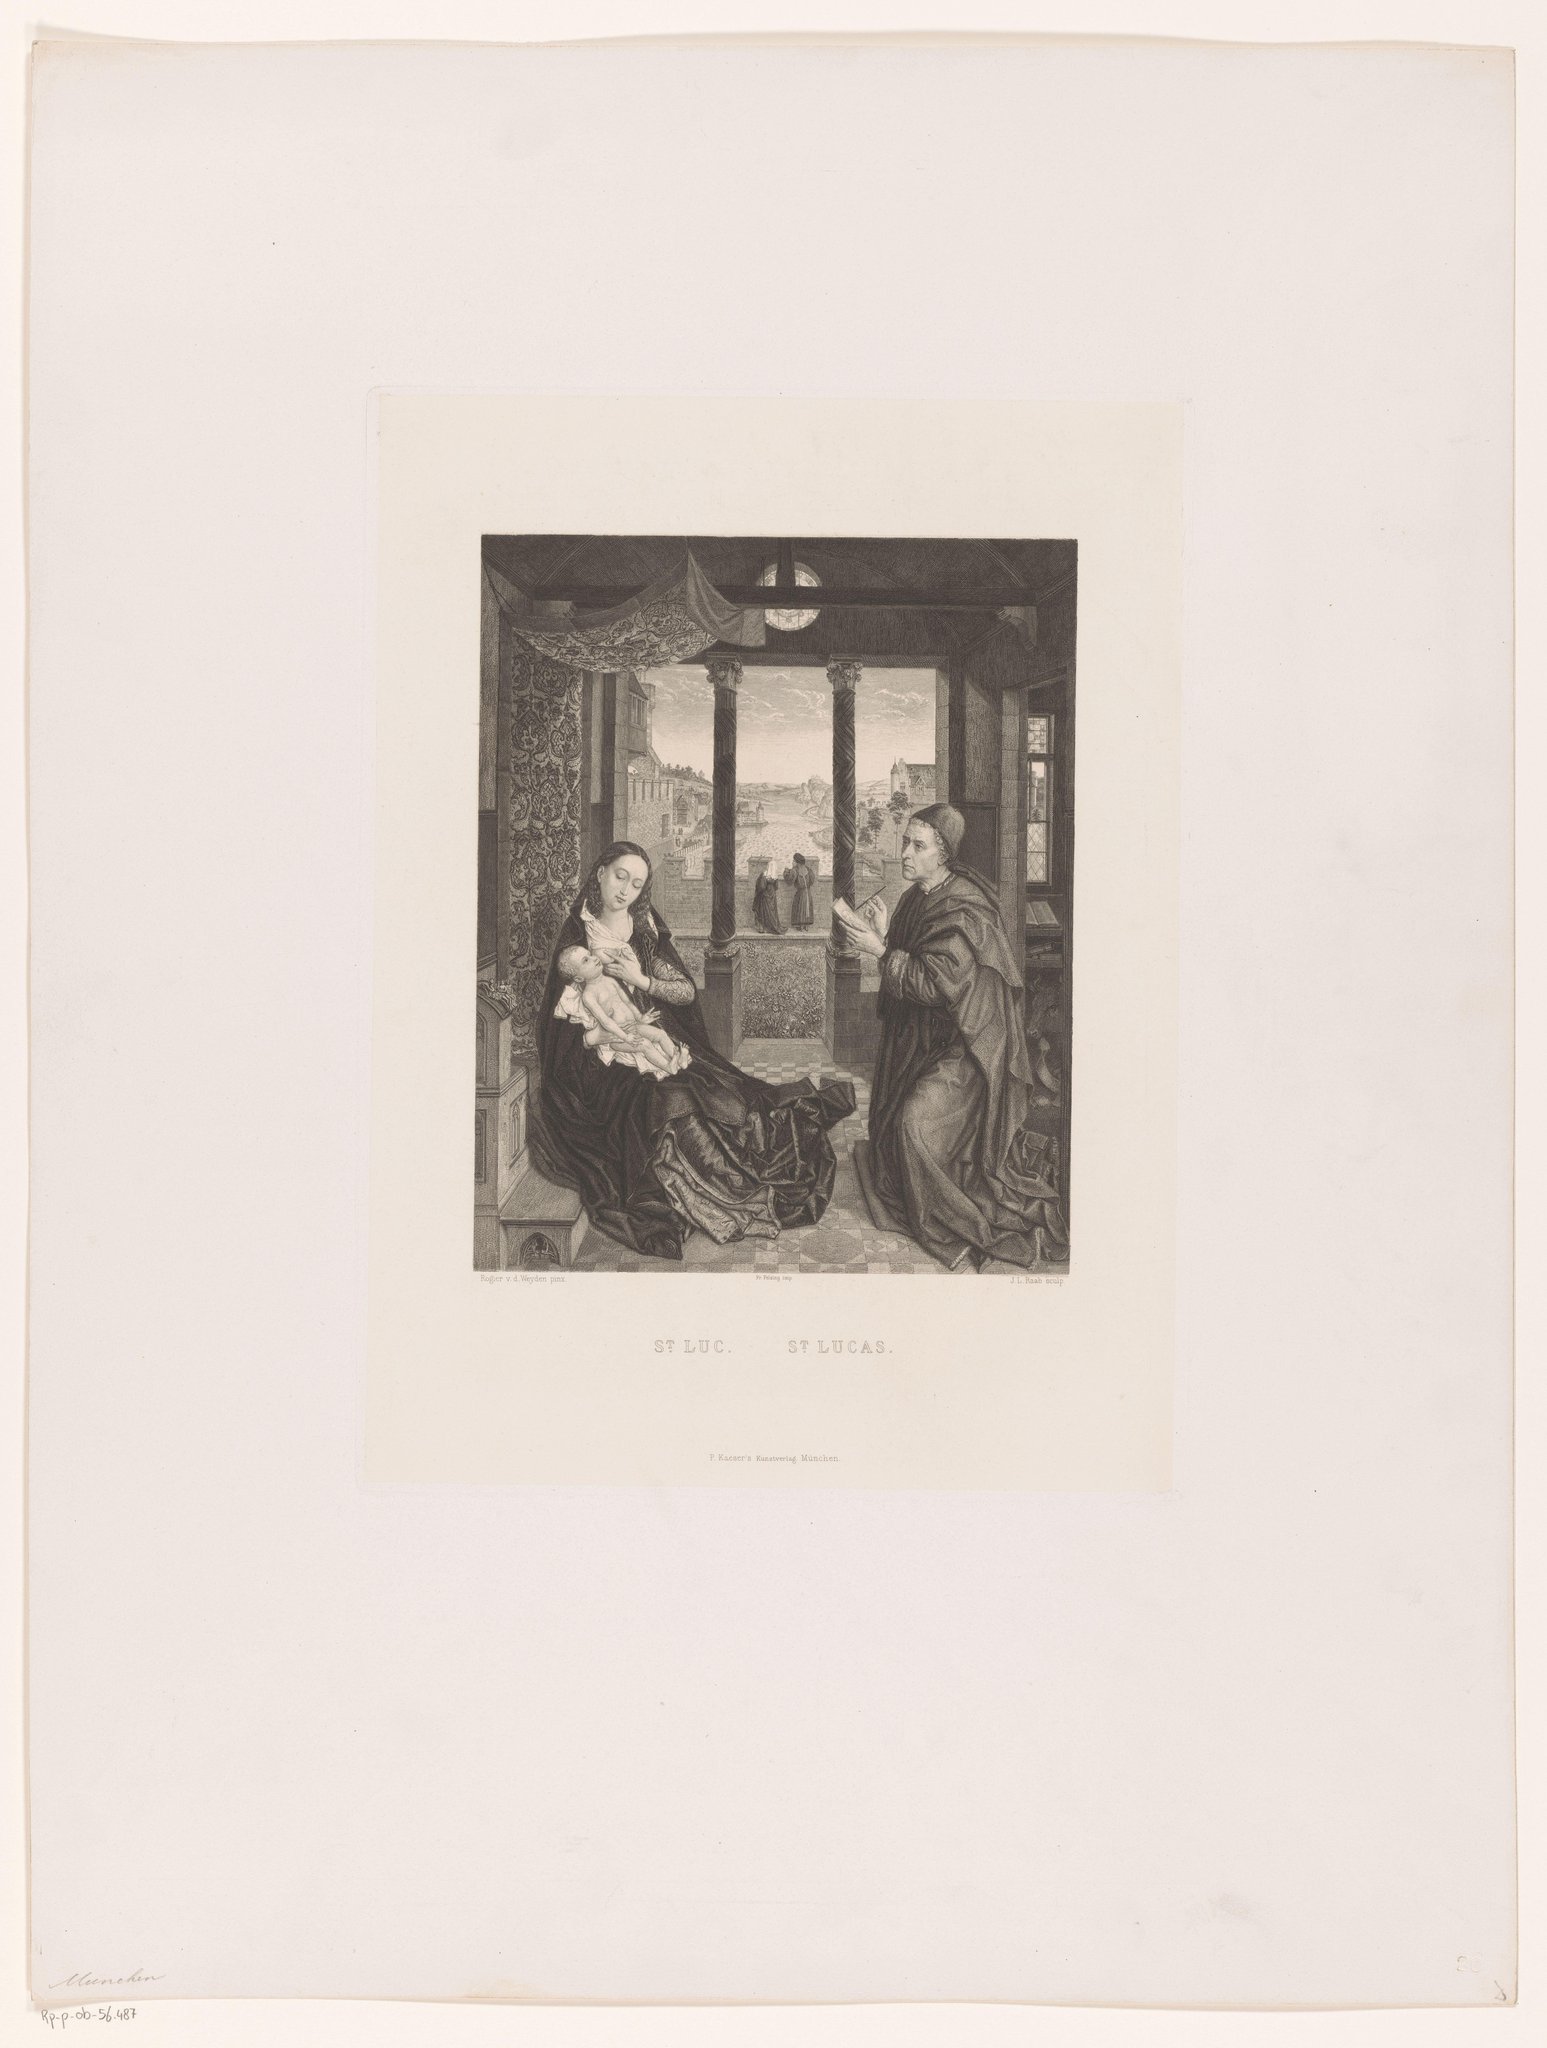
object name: print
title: H. Lucas schildert Maria met kind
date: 1835-1899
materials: paper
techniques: etching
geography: munich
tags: st.luke painting or drawing the madonna (i.e. mary and the christ-child), sometimes joseph present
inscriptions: number: ‘20’, collector's mark: Lugt 2228